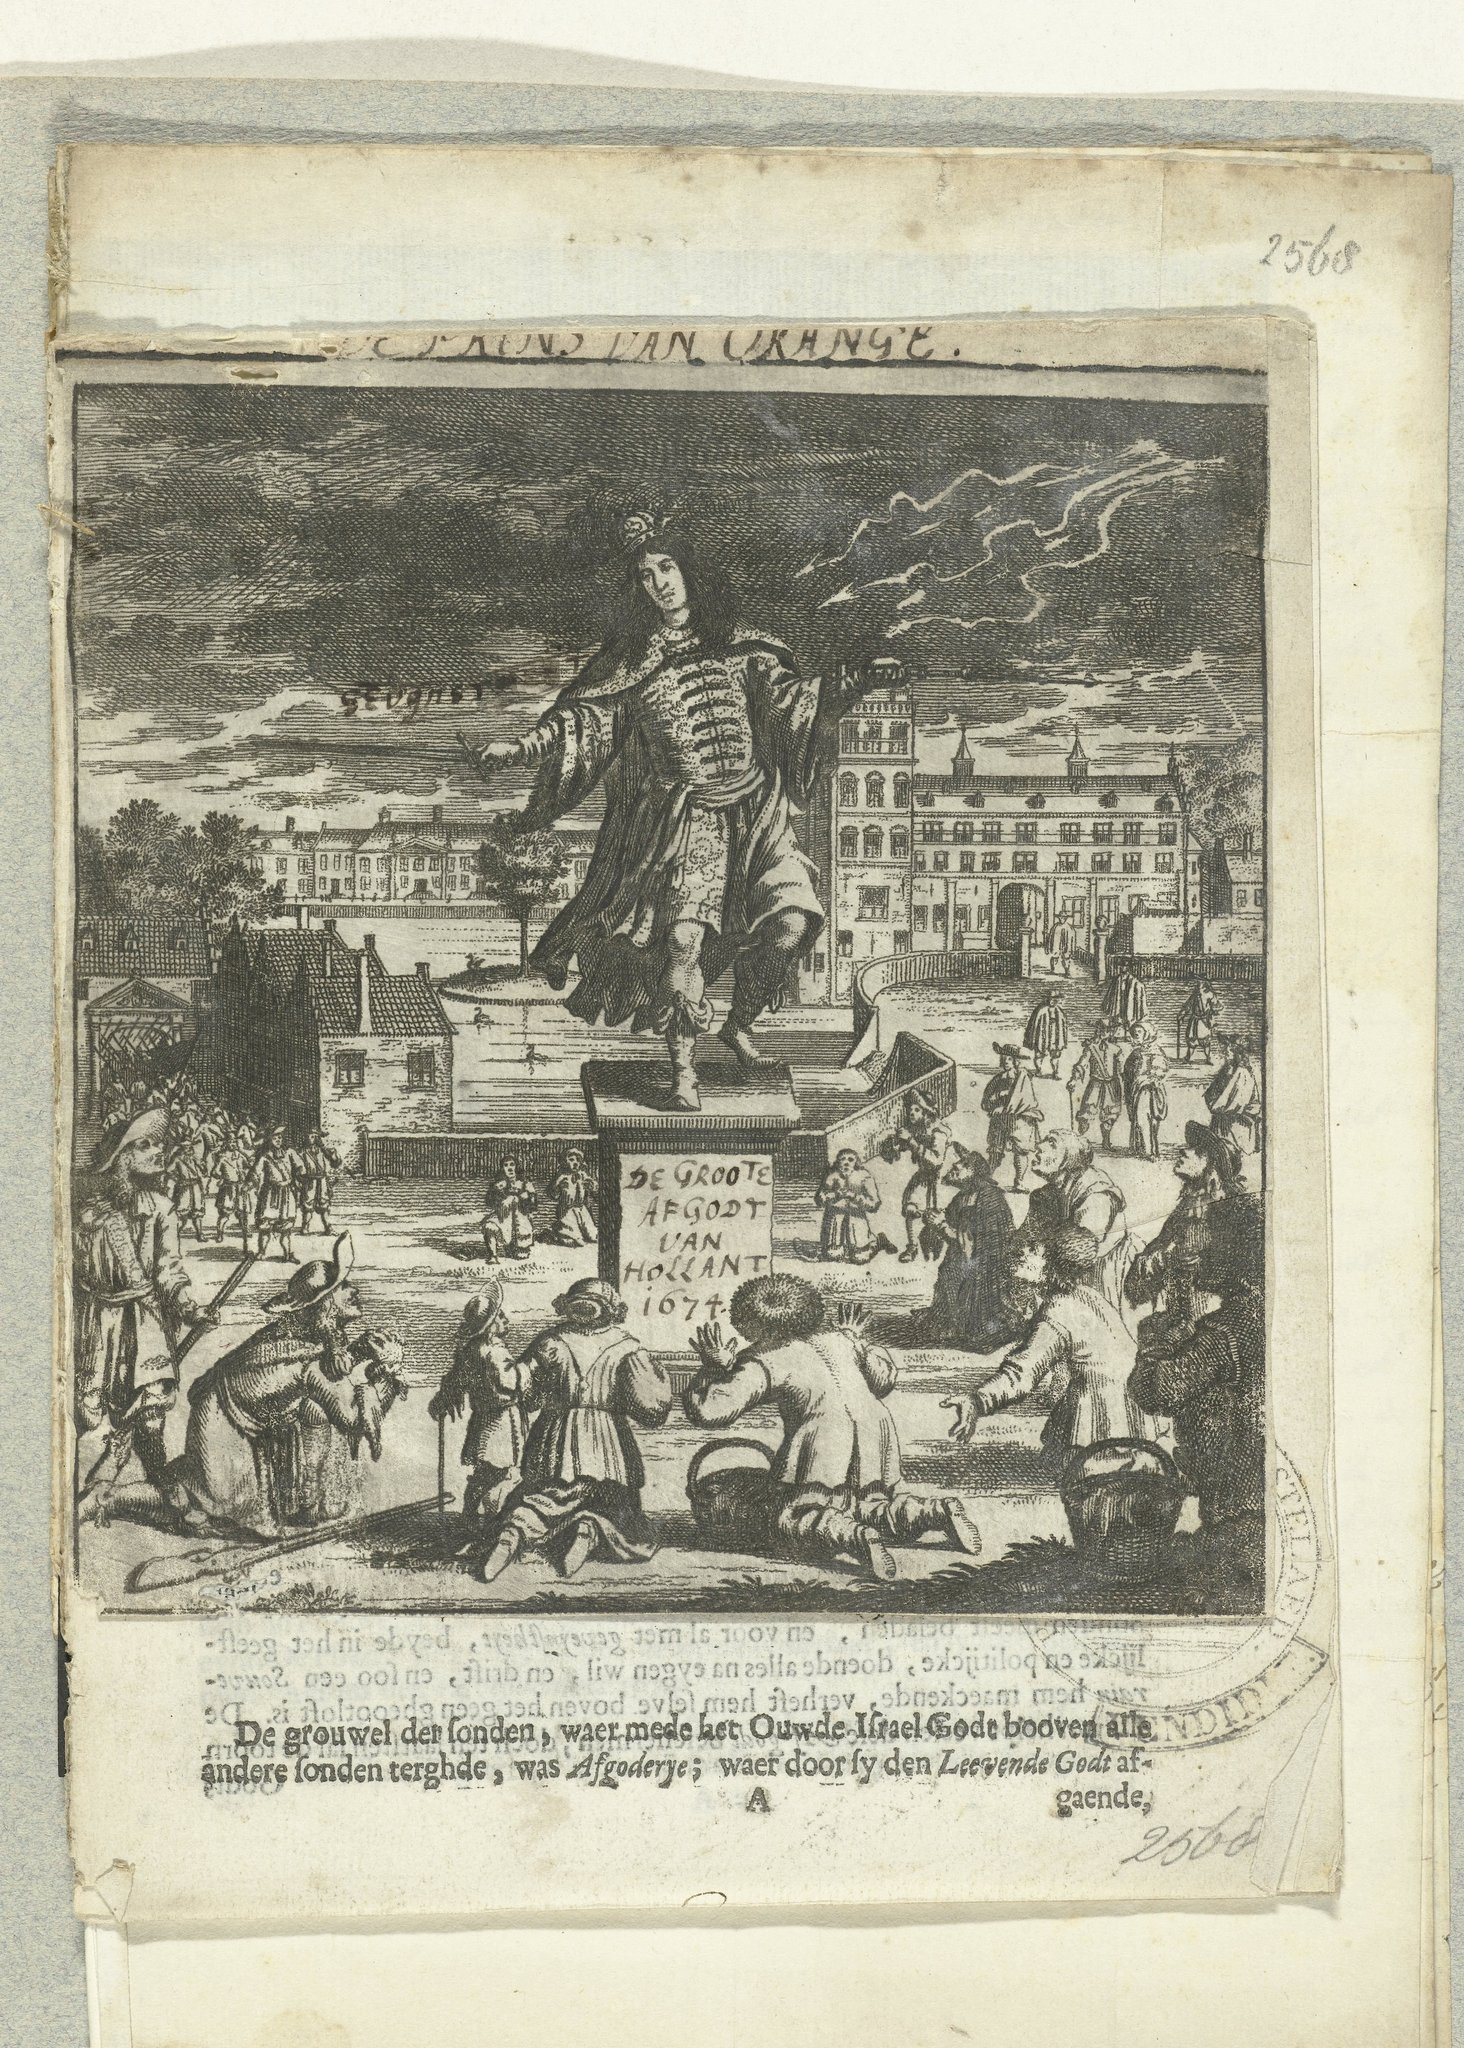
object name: titelblad, titelpagina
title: Titelpagina voor een pamflet van Johannes Rothe, 1674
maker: Anonymous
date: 1674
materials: paper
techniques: etching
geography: northern netherlands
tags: william iii (prince of orange and king of england, scotland, and ireland)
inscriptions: collector's mark: ‘Biblioth. Amstelaed. Vendidit’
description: Allegorische titelpagina voor een pamflet tegen Willem III van Johannes Rothe, 1674. Een groot beeld van stadhouder Willem III voor het Stadhouderlijk Kwartier op het Buitenhof te Den Haag wordt aanbeden door knielende burgers. Vanuit de hemel schieten bliksemschichten naar het beeld. Op het voetstuk van het standbeeld is geschreven: De Groote Afgodt van Hollant 1674. In het pamflet maakt de schrijver al melding van het voorgenomen huwelijk van Willem III met Maria Stuart, de dochter van de katholieke koning Jacobus II van Engeland.